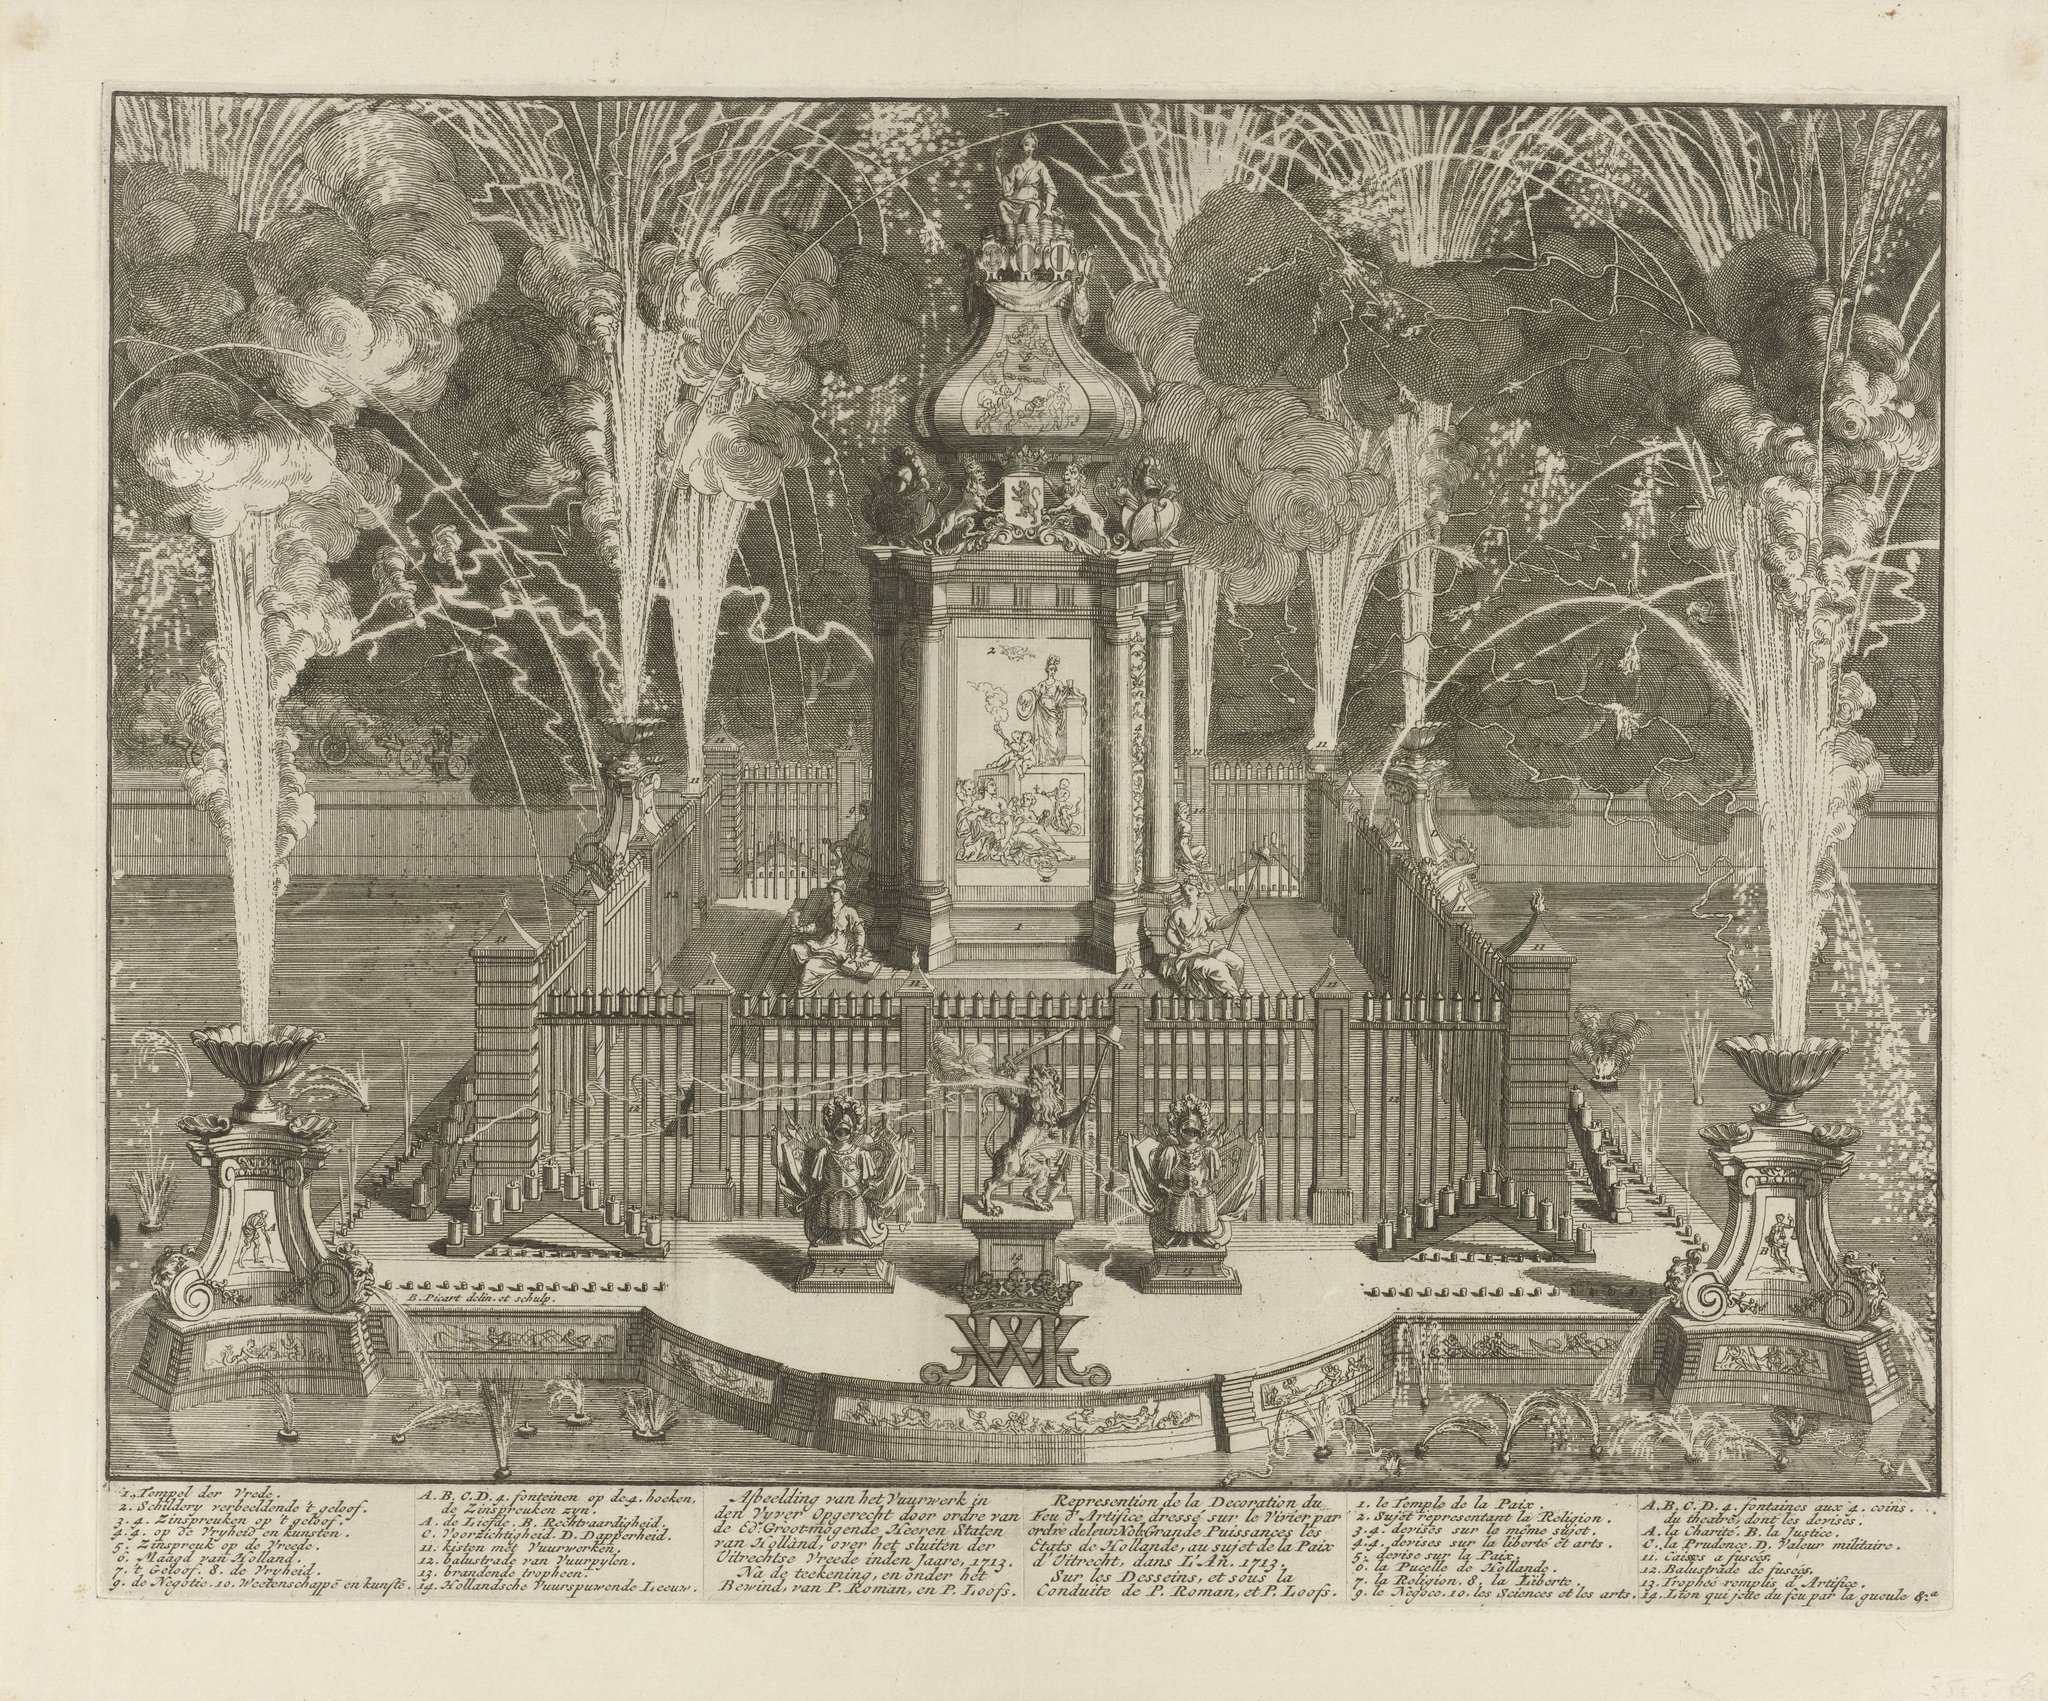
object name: print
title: Vuurwerk bij de viering van de Vrede van Utrecht, 1713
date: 1713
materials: paper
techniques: engraving, etching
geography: amsterdam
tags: bonfire, fire-works (+ illumination, fire-works ~ festive activities)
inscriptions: collector's mark: Lugt 240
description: Stellage met vuurwerk afgestoken in opdracht van de Staten van Holland en West-Friesland op de Hofvijver te 's-Gravenhage bij de viering van de Vrede van Utrecht, 14 juni 1713. Centraal de tempel van Janus bekroond door de Hollandse Maagd met vrijheidshoed in de Hollandse Tuin. De Tempel omringd door zittende figuren van Geloof, Vrijheid, Koophandel, Wetenschap en de Kunsten. Onderaan de verklaring van de cijfers 1-14 in het Nederlands en Frans.